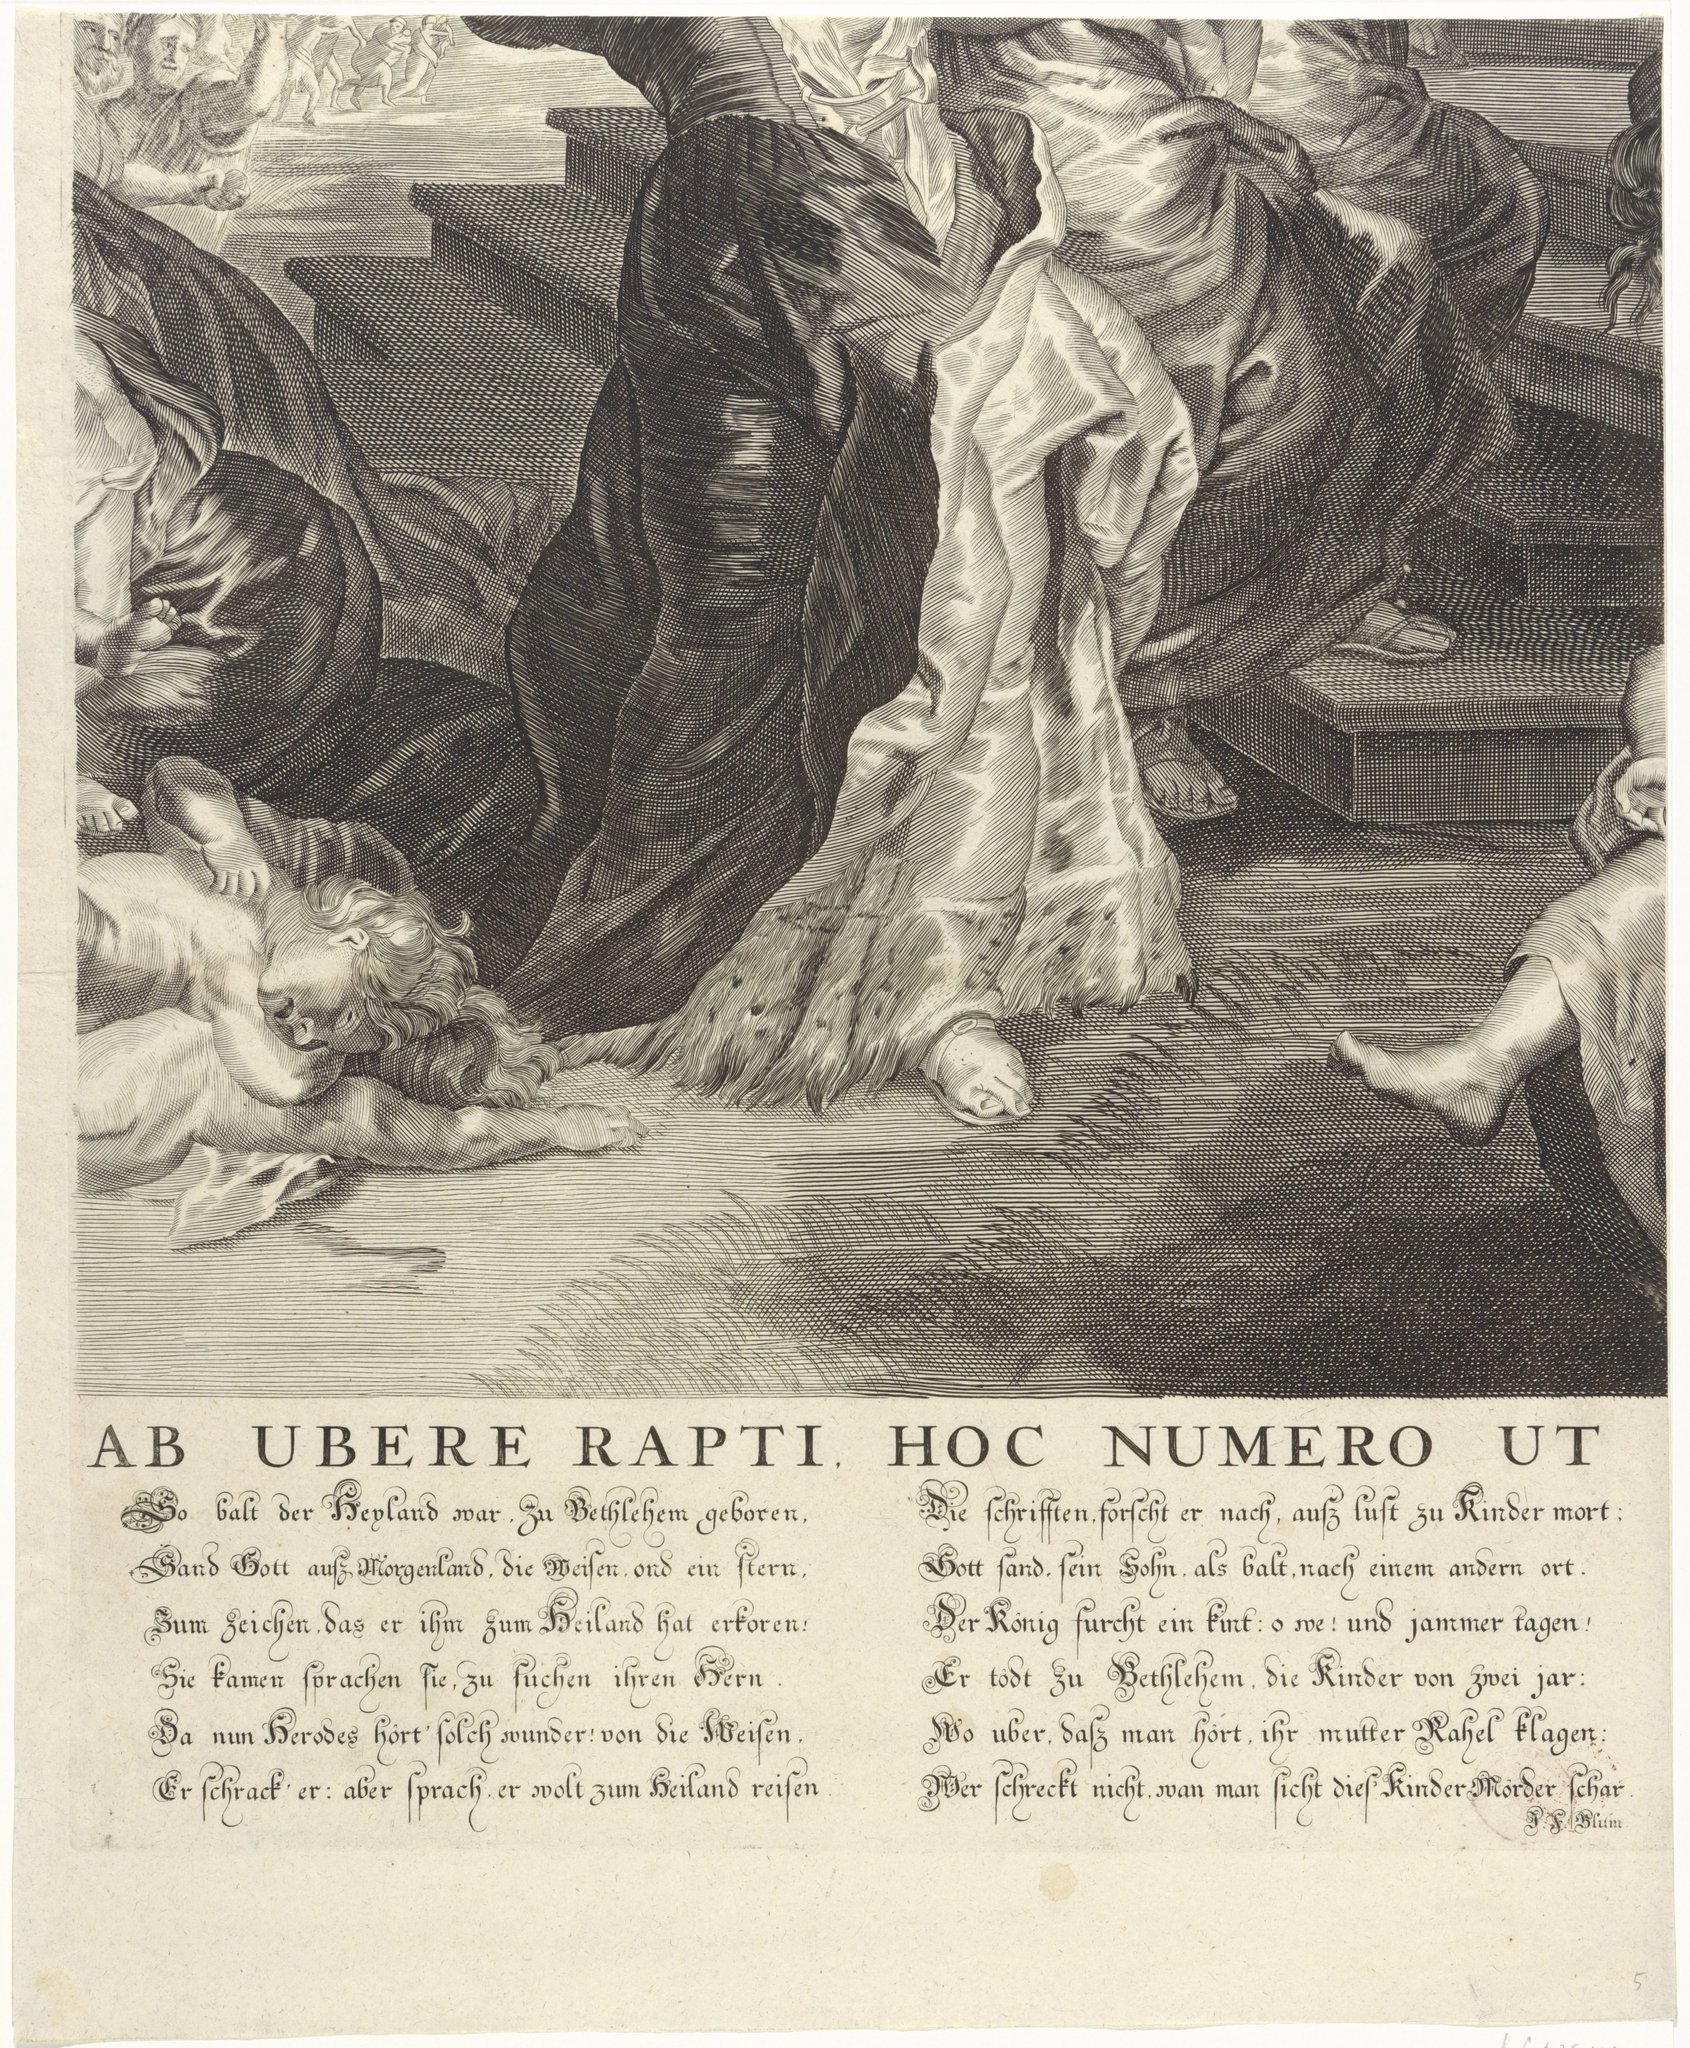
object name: print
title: Kindermoord te Betlehem, midden onder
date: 1668-1693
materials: paper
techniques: engraving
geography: amsterdam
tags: the massacre of the innocents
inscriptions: collector's mark: Lugt 240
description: Fragment van de kindermoord te Betlehem. Nabij Herodes' paleis vindt een grote slachtpartij plaats. Wanhopige moeders proberen hun kinderen te beschermen tegen de soldaten van Herodes. In de marge een twaalfregelig onderschrift, in twee kolommen, in het Duits.